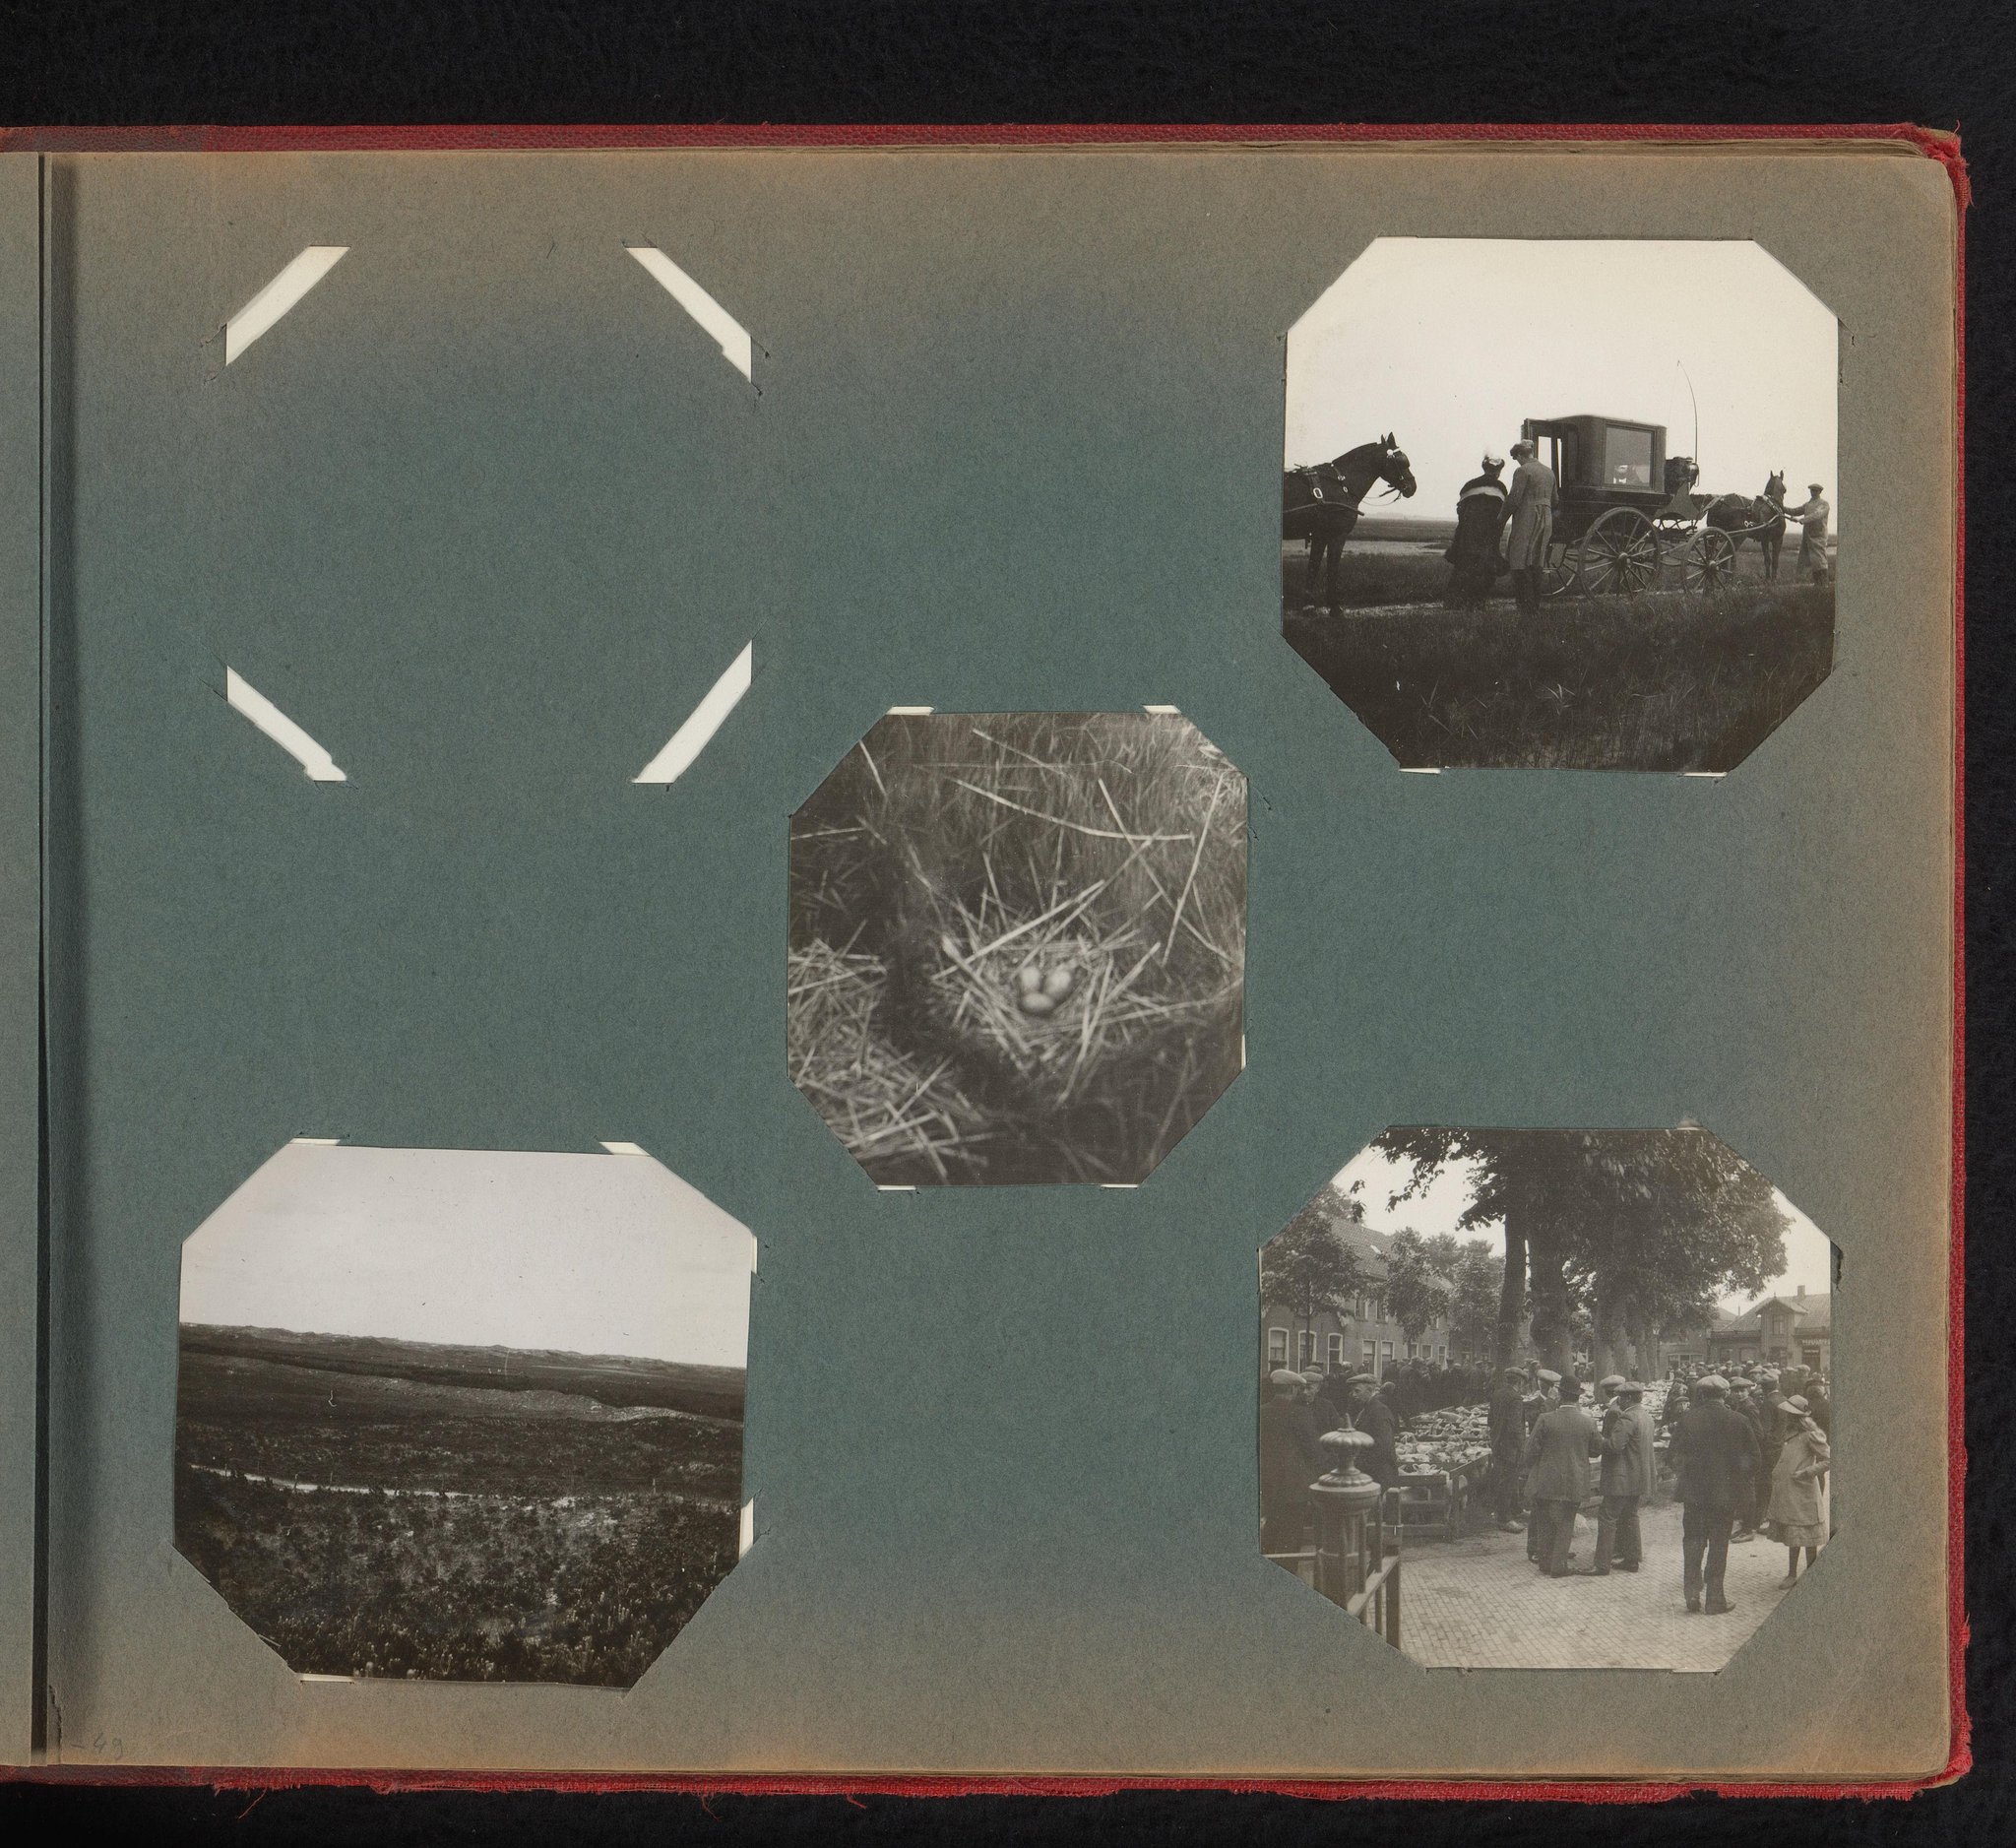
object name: photograph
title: Joan en Charlotte Boelen op Texel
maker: charlotte alida boelen-matthes (lot)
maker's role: amateurfotograaf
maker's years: 1889-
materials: paper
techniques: gelatin silver print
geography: texel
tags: dunes (sea not visible); in the dunes, market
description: Deze foto's zijn onderdeel van een album.